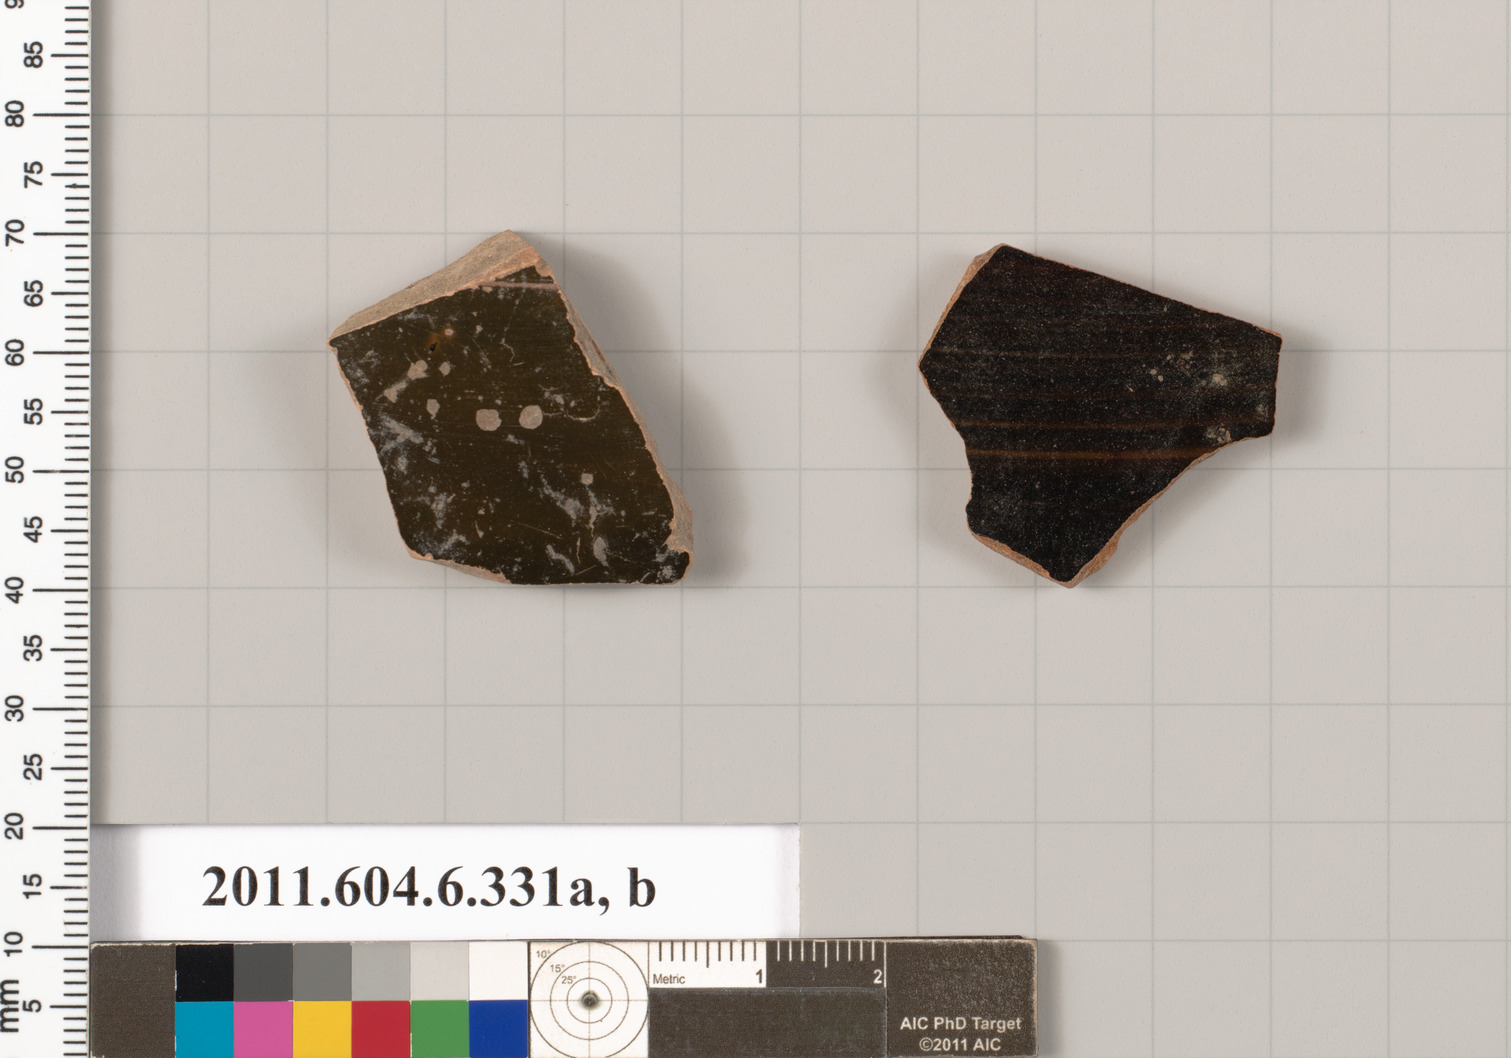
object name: open shape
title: Terracotta fragments of open shapes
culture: greek, attic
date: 600-401 BCE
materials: terracotta